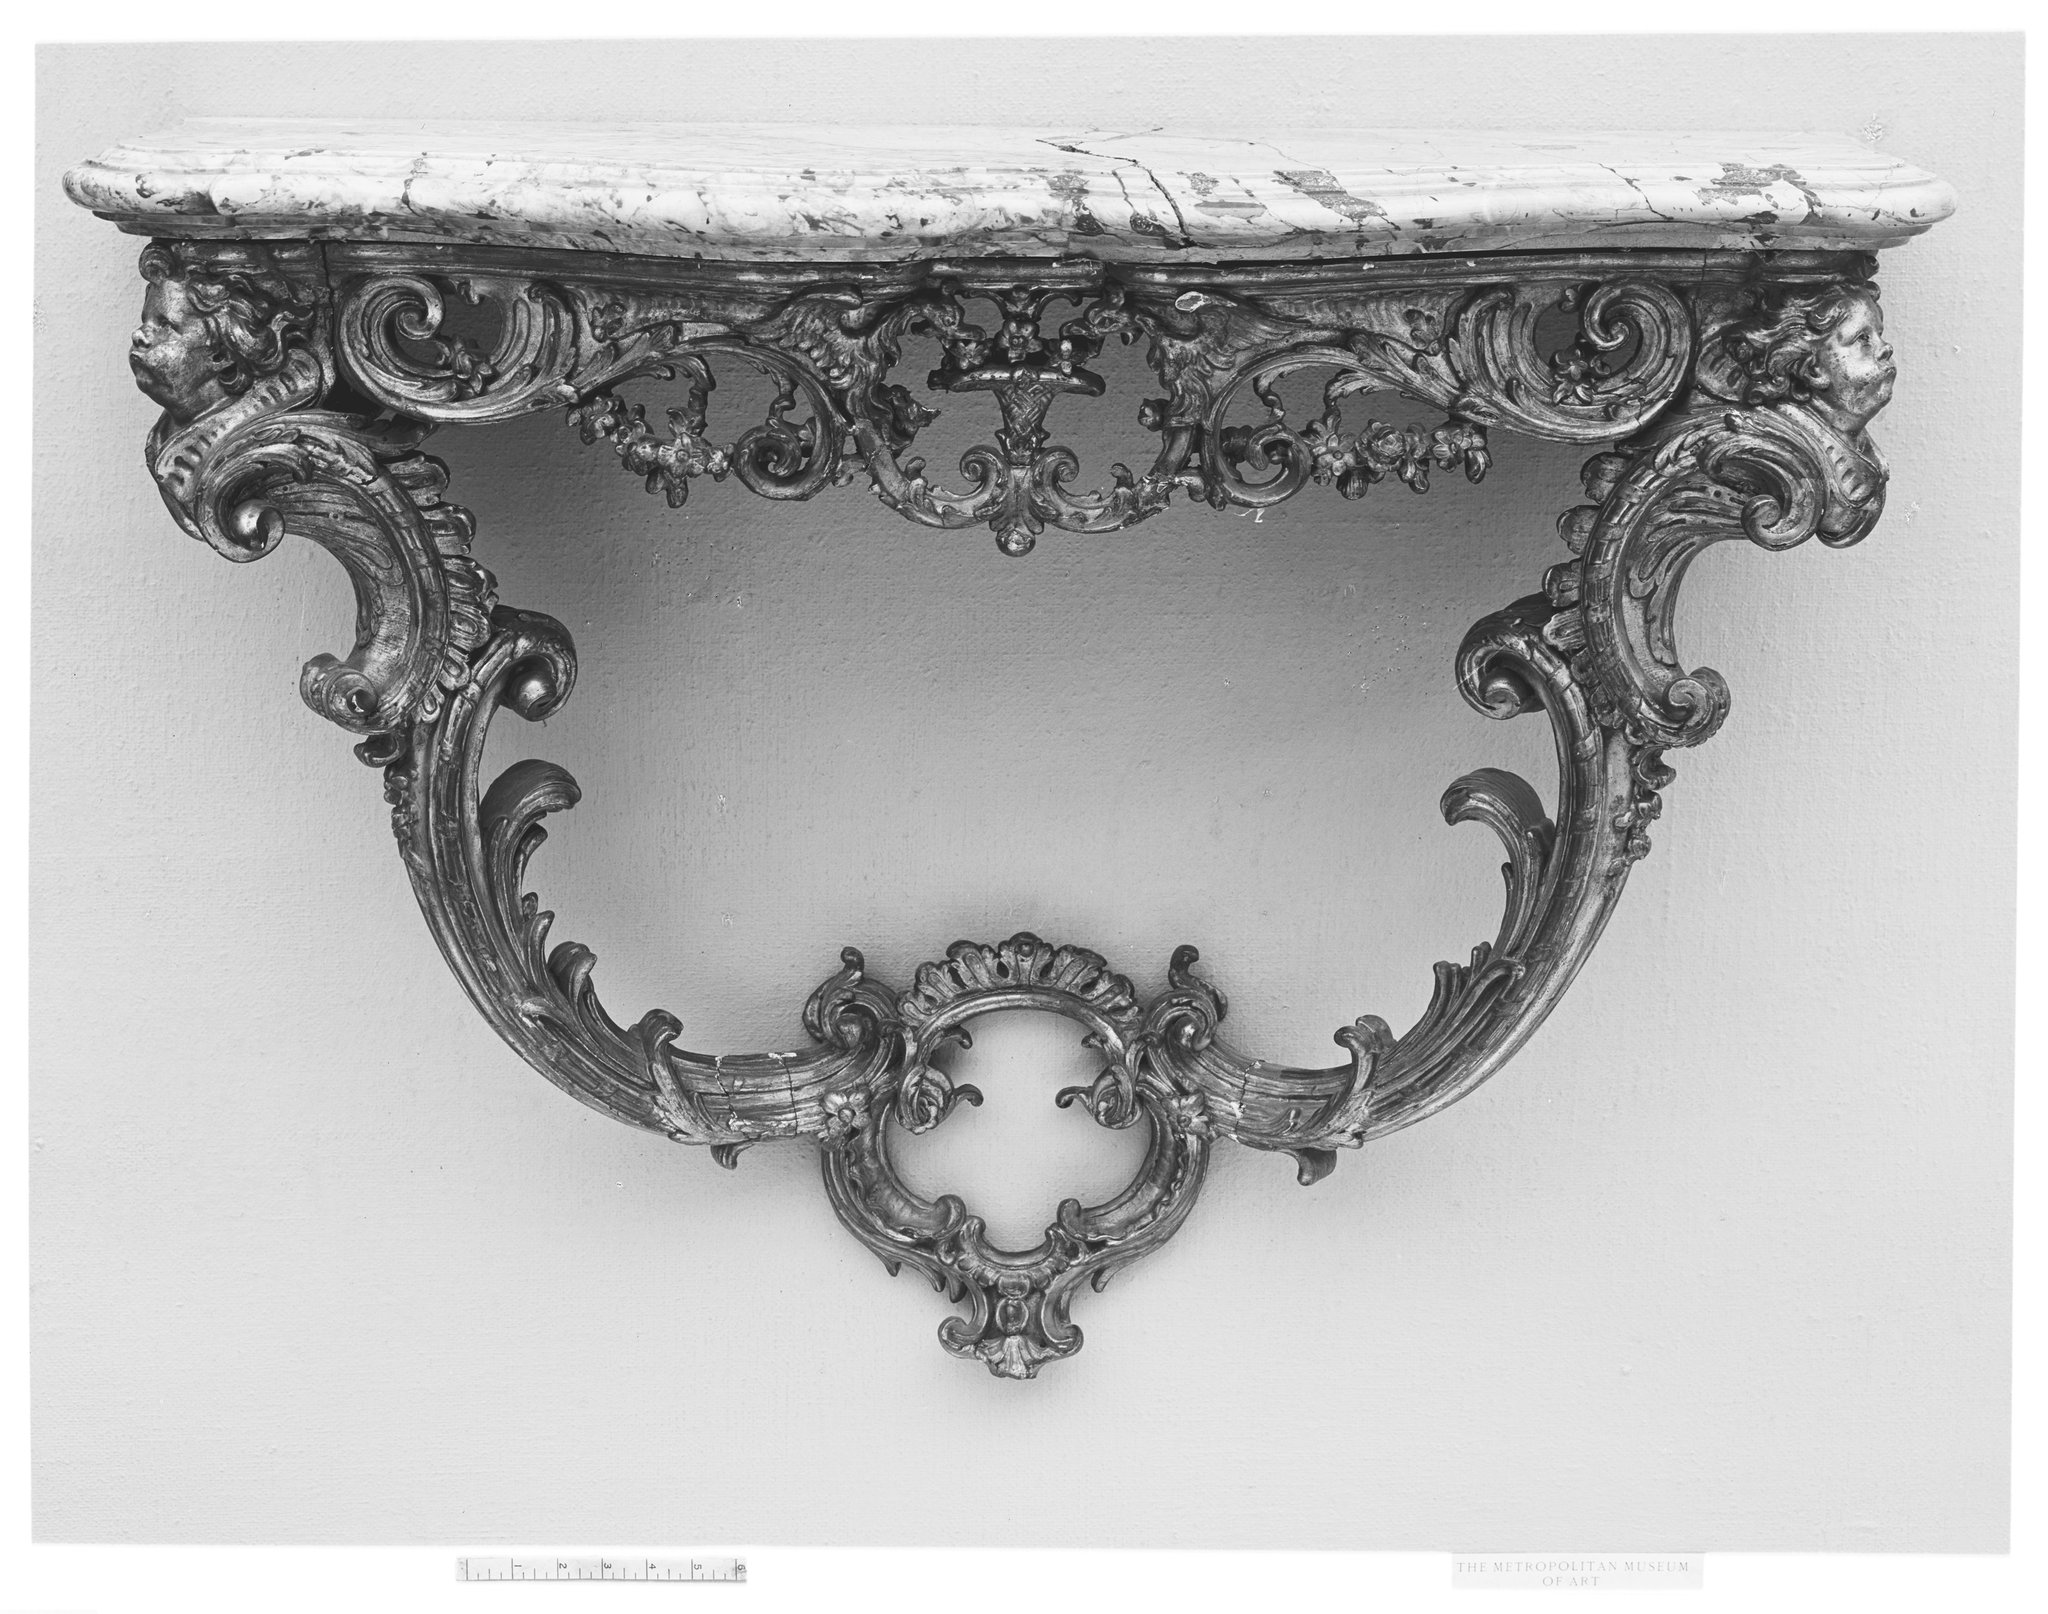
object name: console table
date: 1701-1800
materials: marble, wood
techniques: carving, gilding